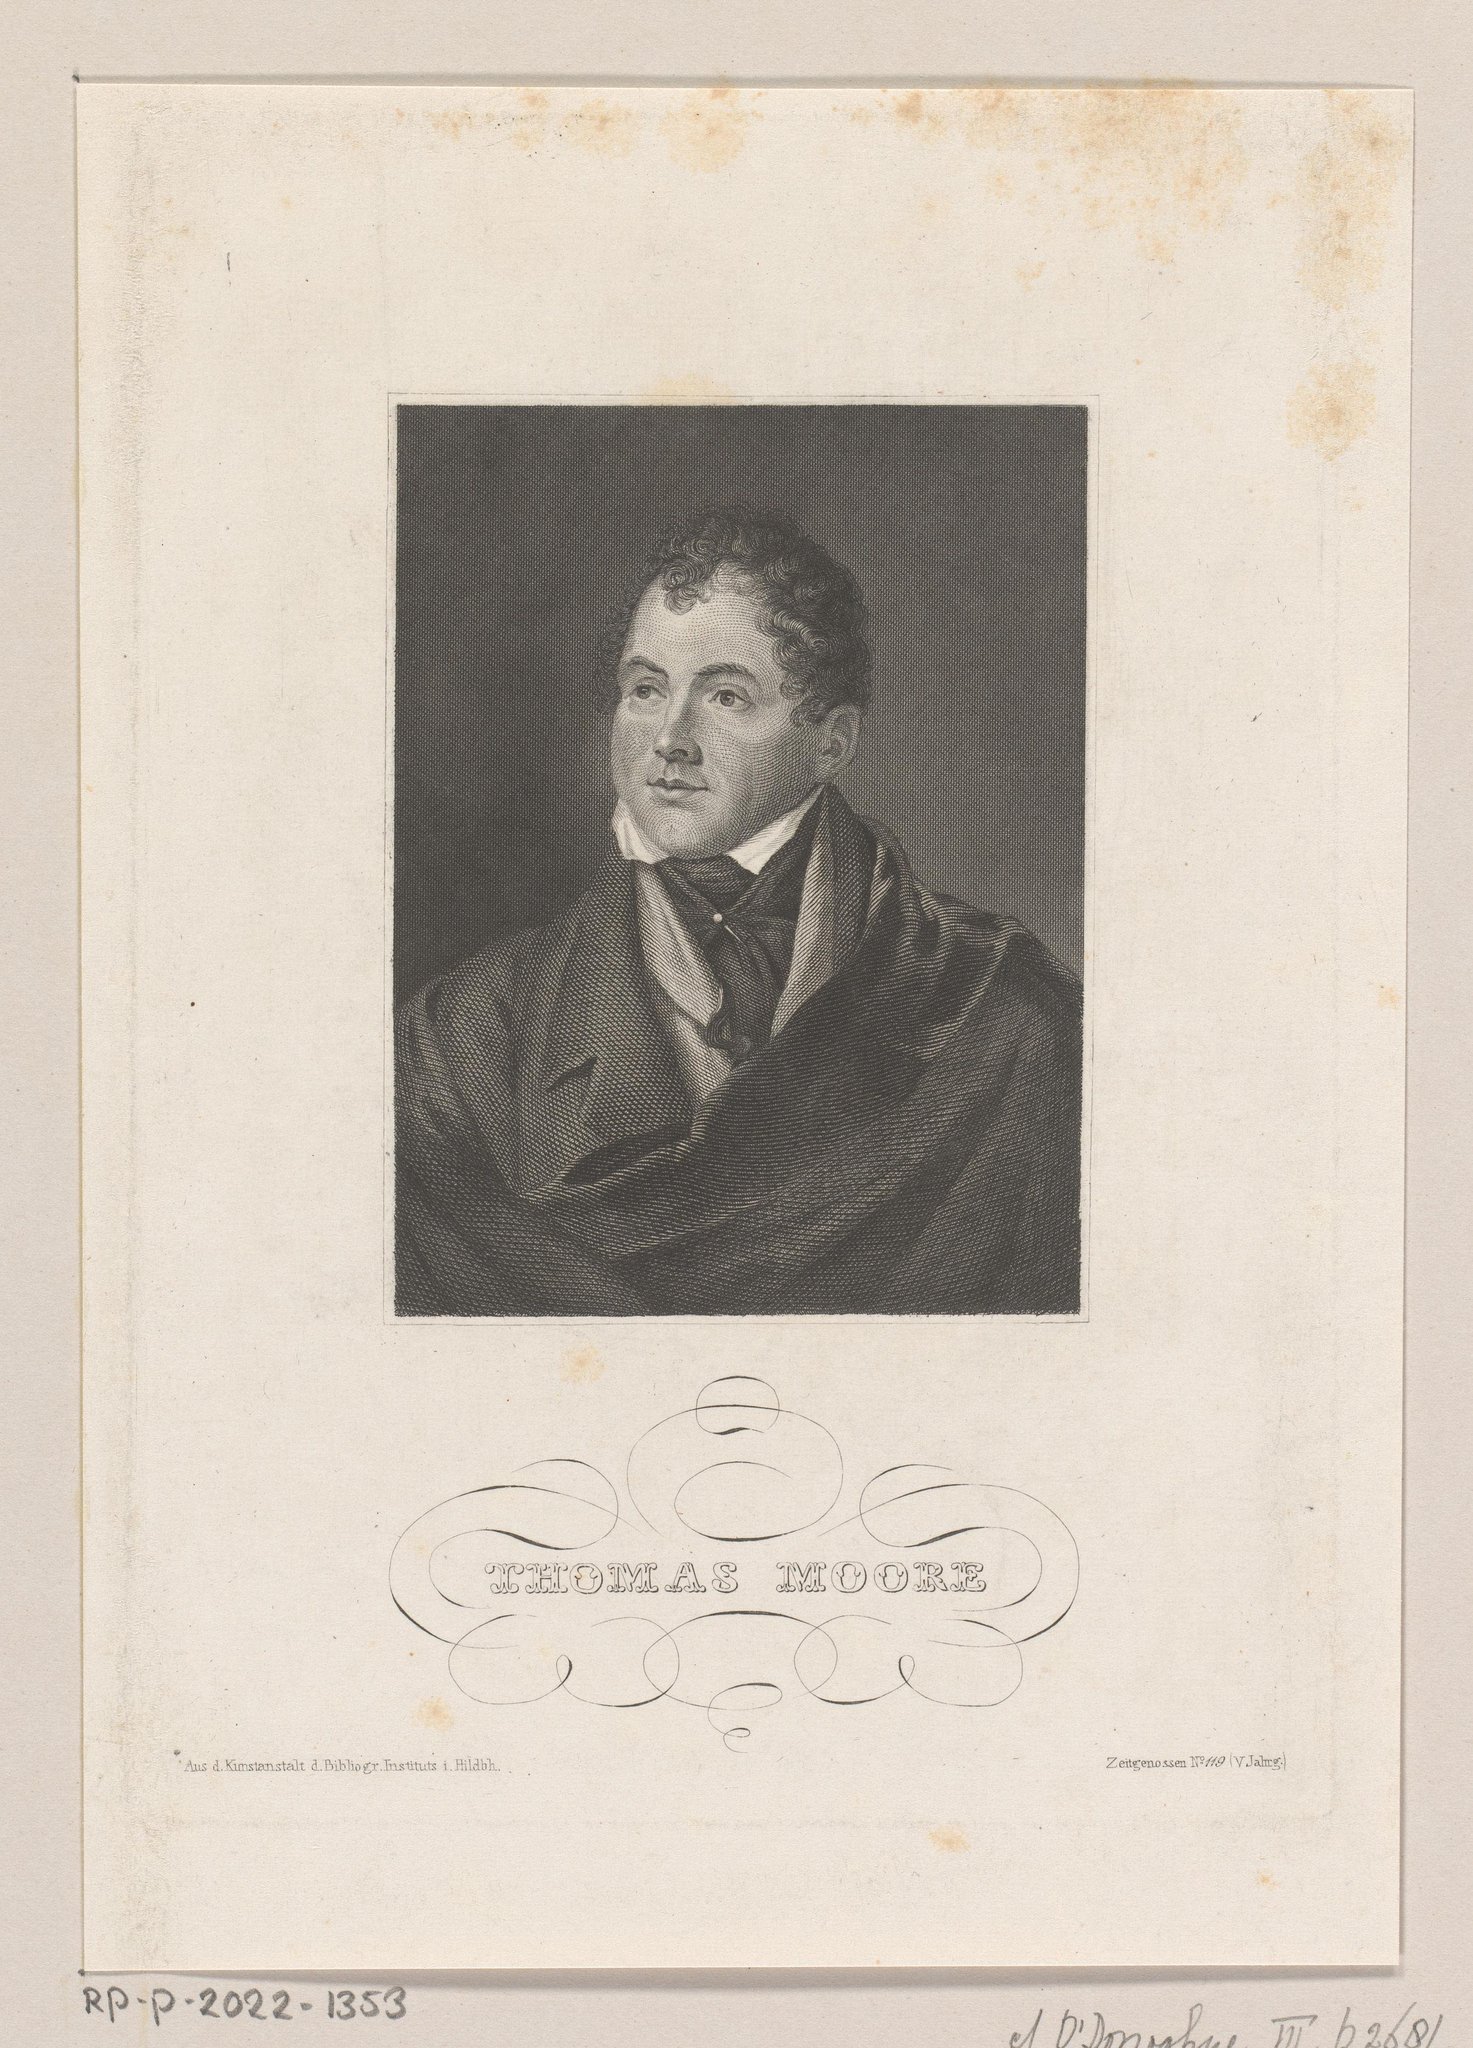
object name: print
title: Thomas Moore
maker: Anonymous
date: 1828-1874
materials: paper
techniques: engraving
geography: hildburghausen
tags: thomas moore, historical persons, writer, poet, author